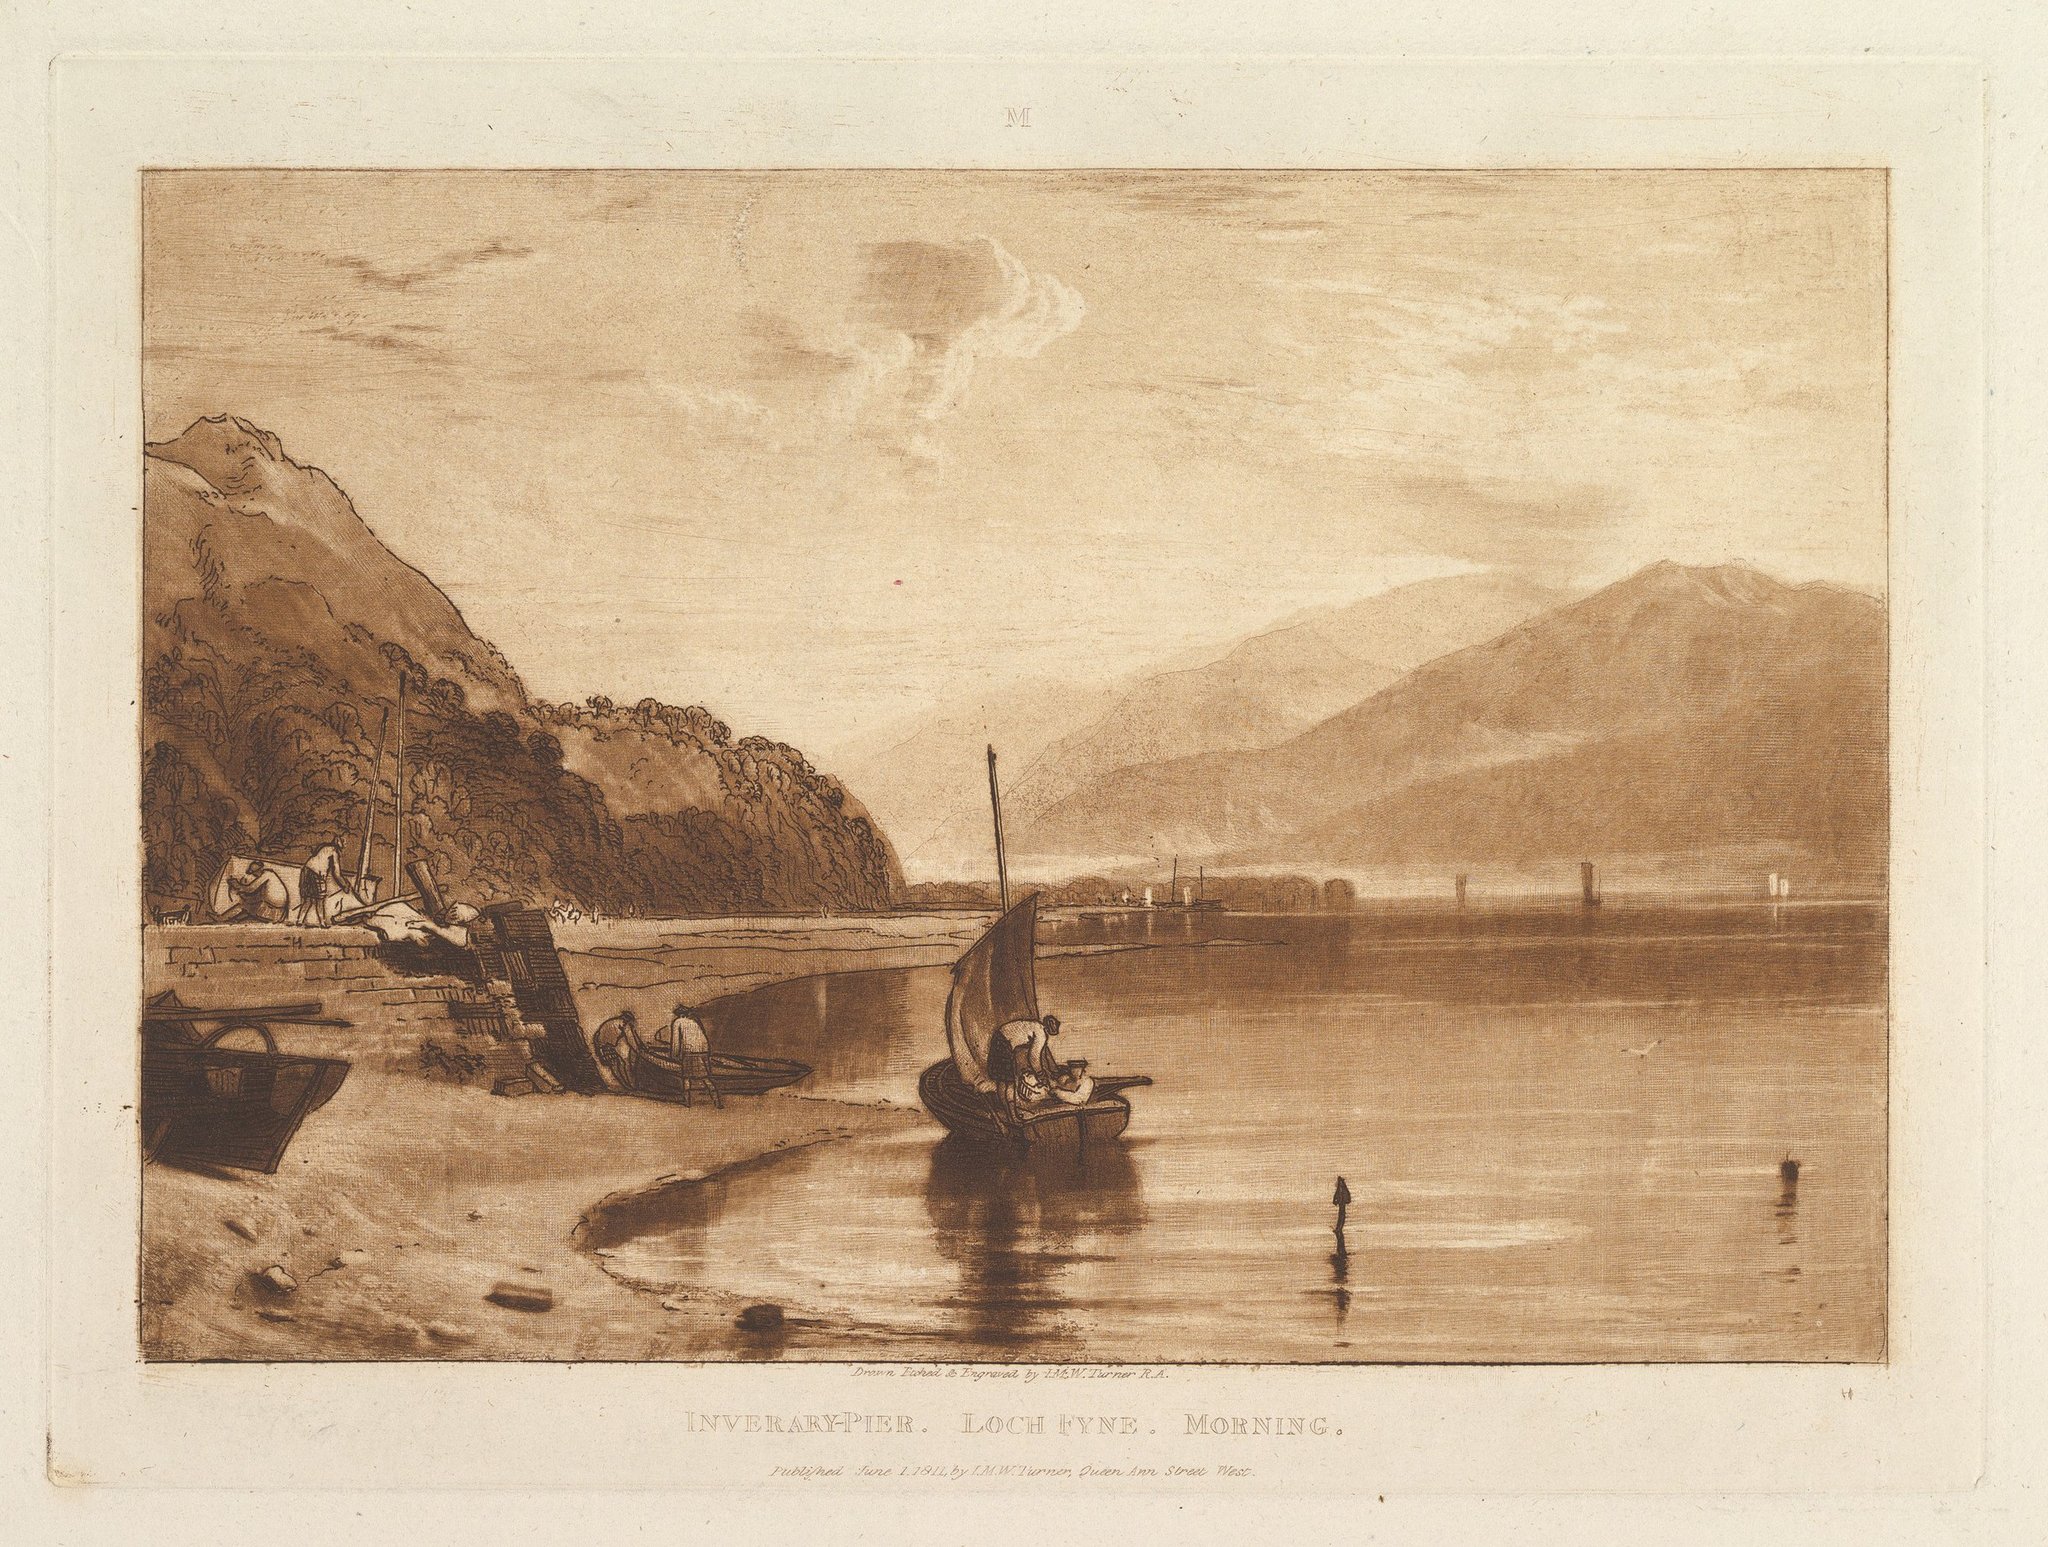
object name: print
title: Inverary Pier, Loch Fyne, Morning (Liber Studiorum, part VII, plate 35)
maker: joseph mallord william turner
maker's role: artist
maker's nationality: british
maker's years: 1775-1851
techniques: aquatint, etching, mezzotint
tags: mountains,morning,boats